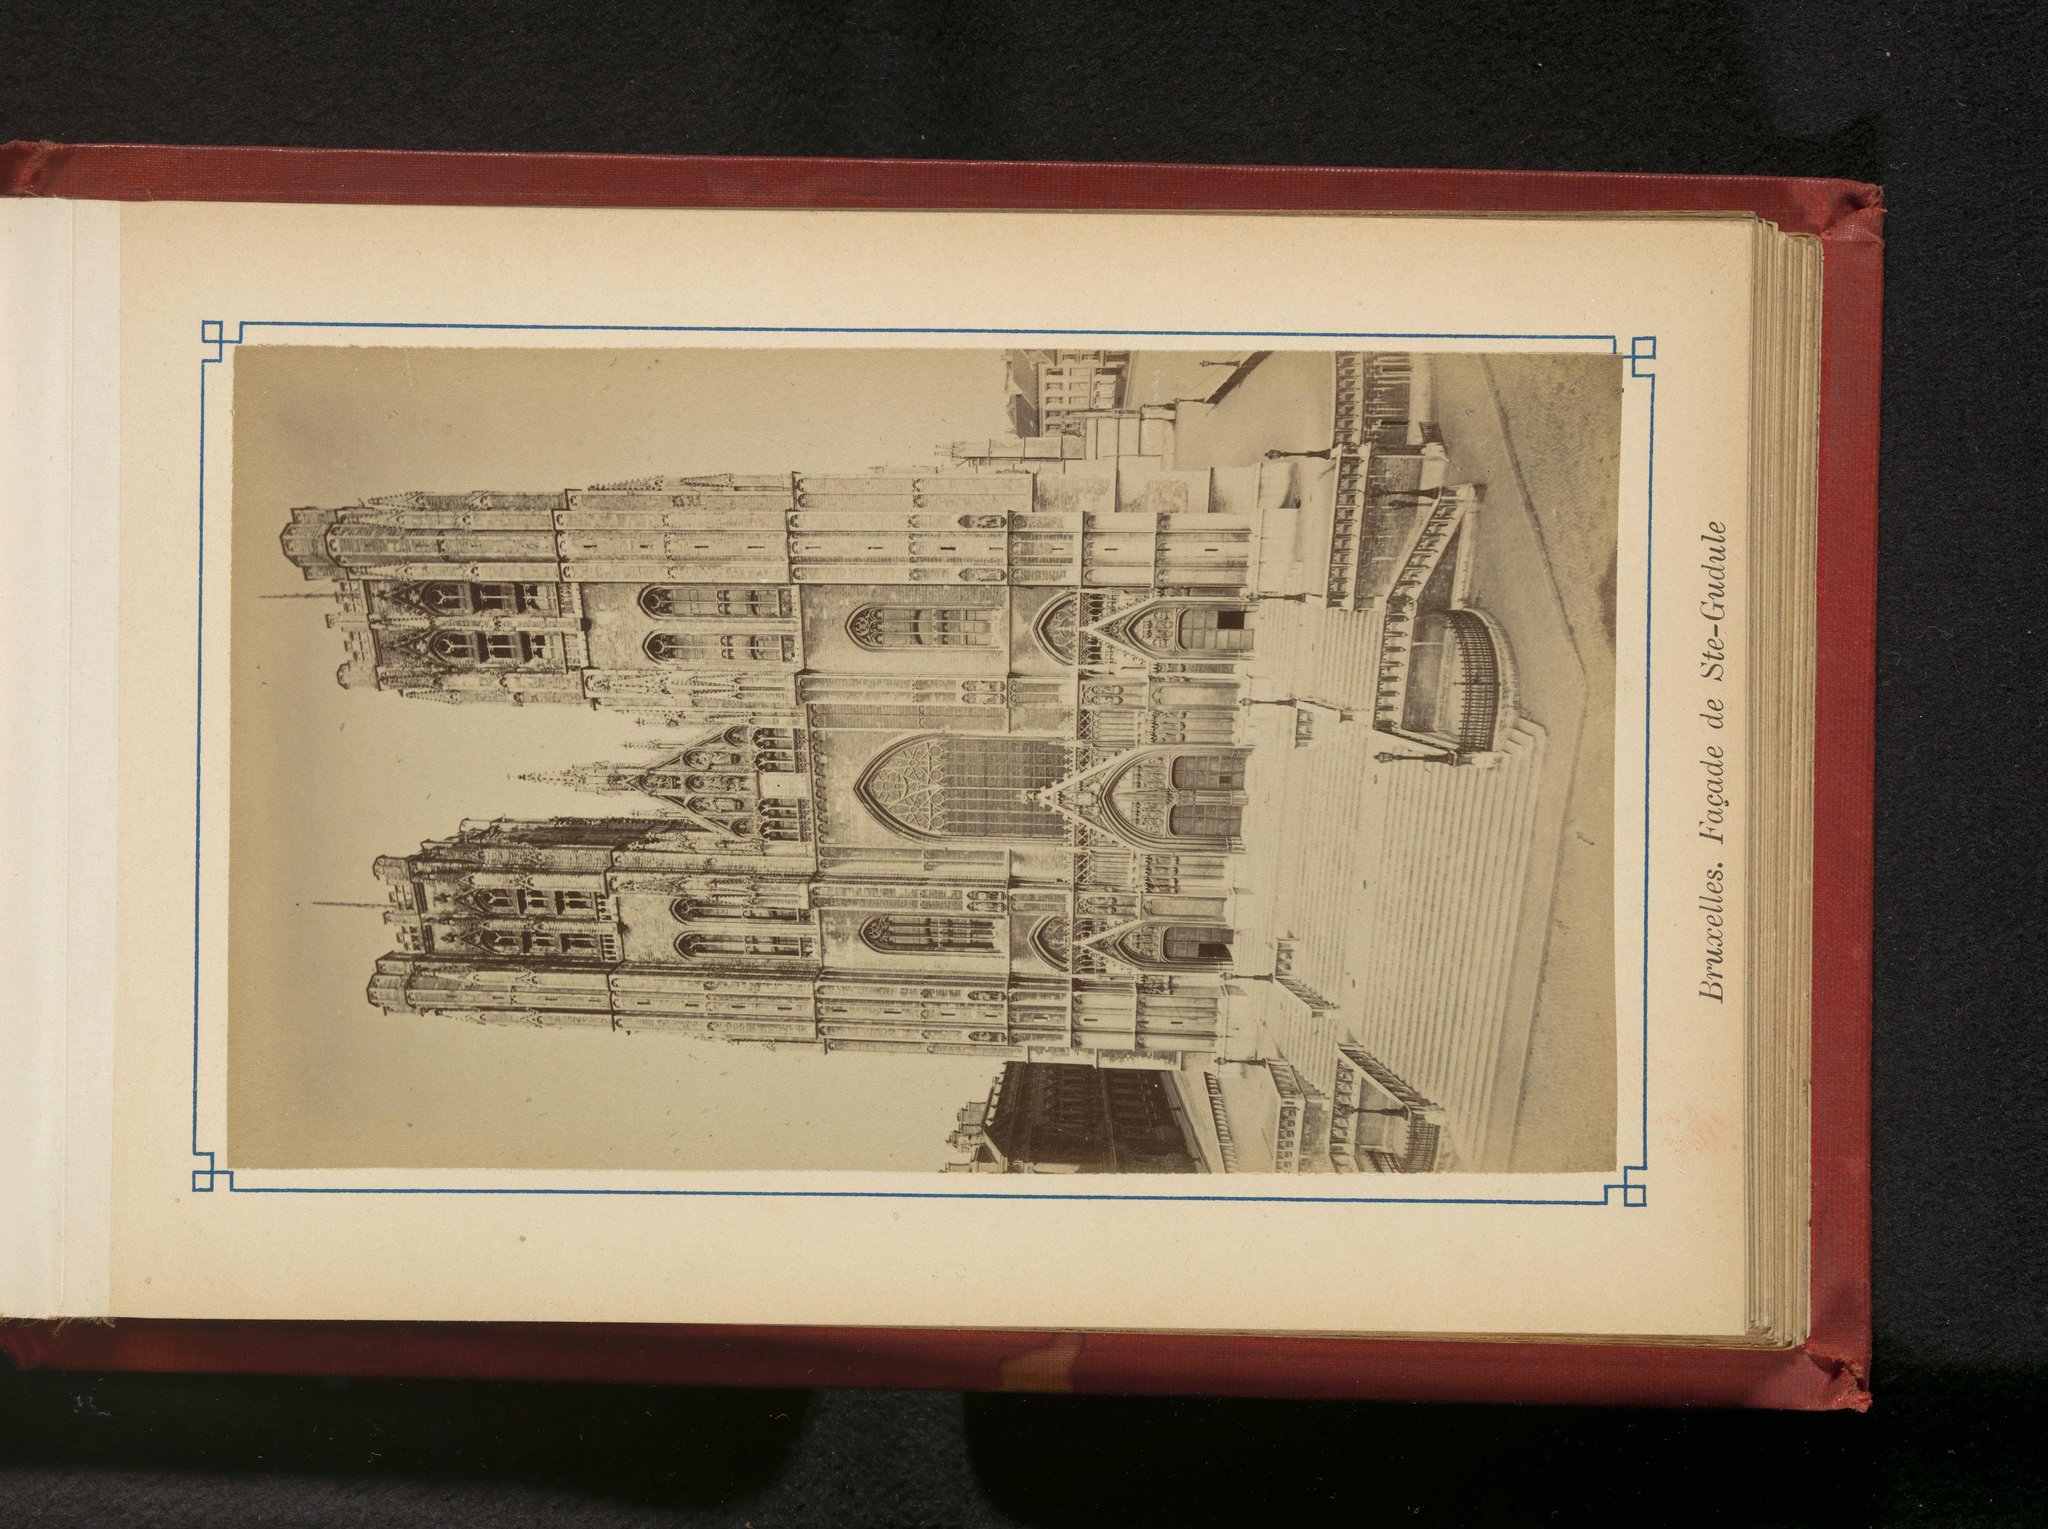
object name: page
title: Bruxelles. Façade de Ste-Gudule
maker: Anonymous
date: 1875-1880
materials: photographic support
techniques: albumen print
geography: brussels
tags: church (exterior), façade (of house or building)